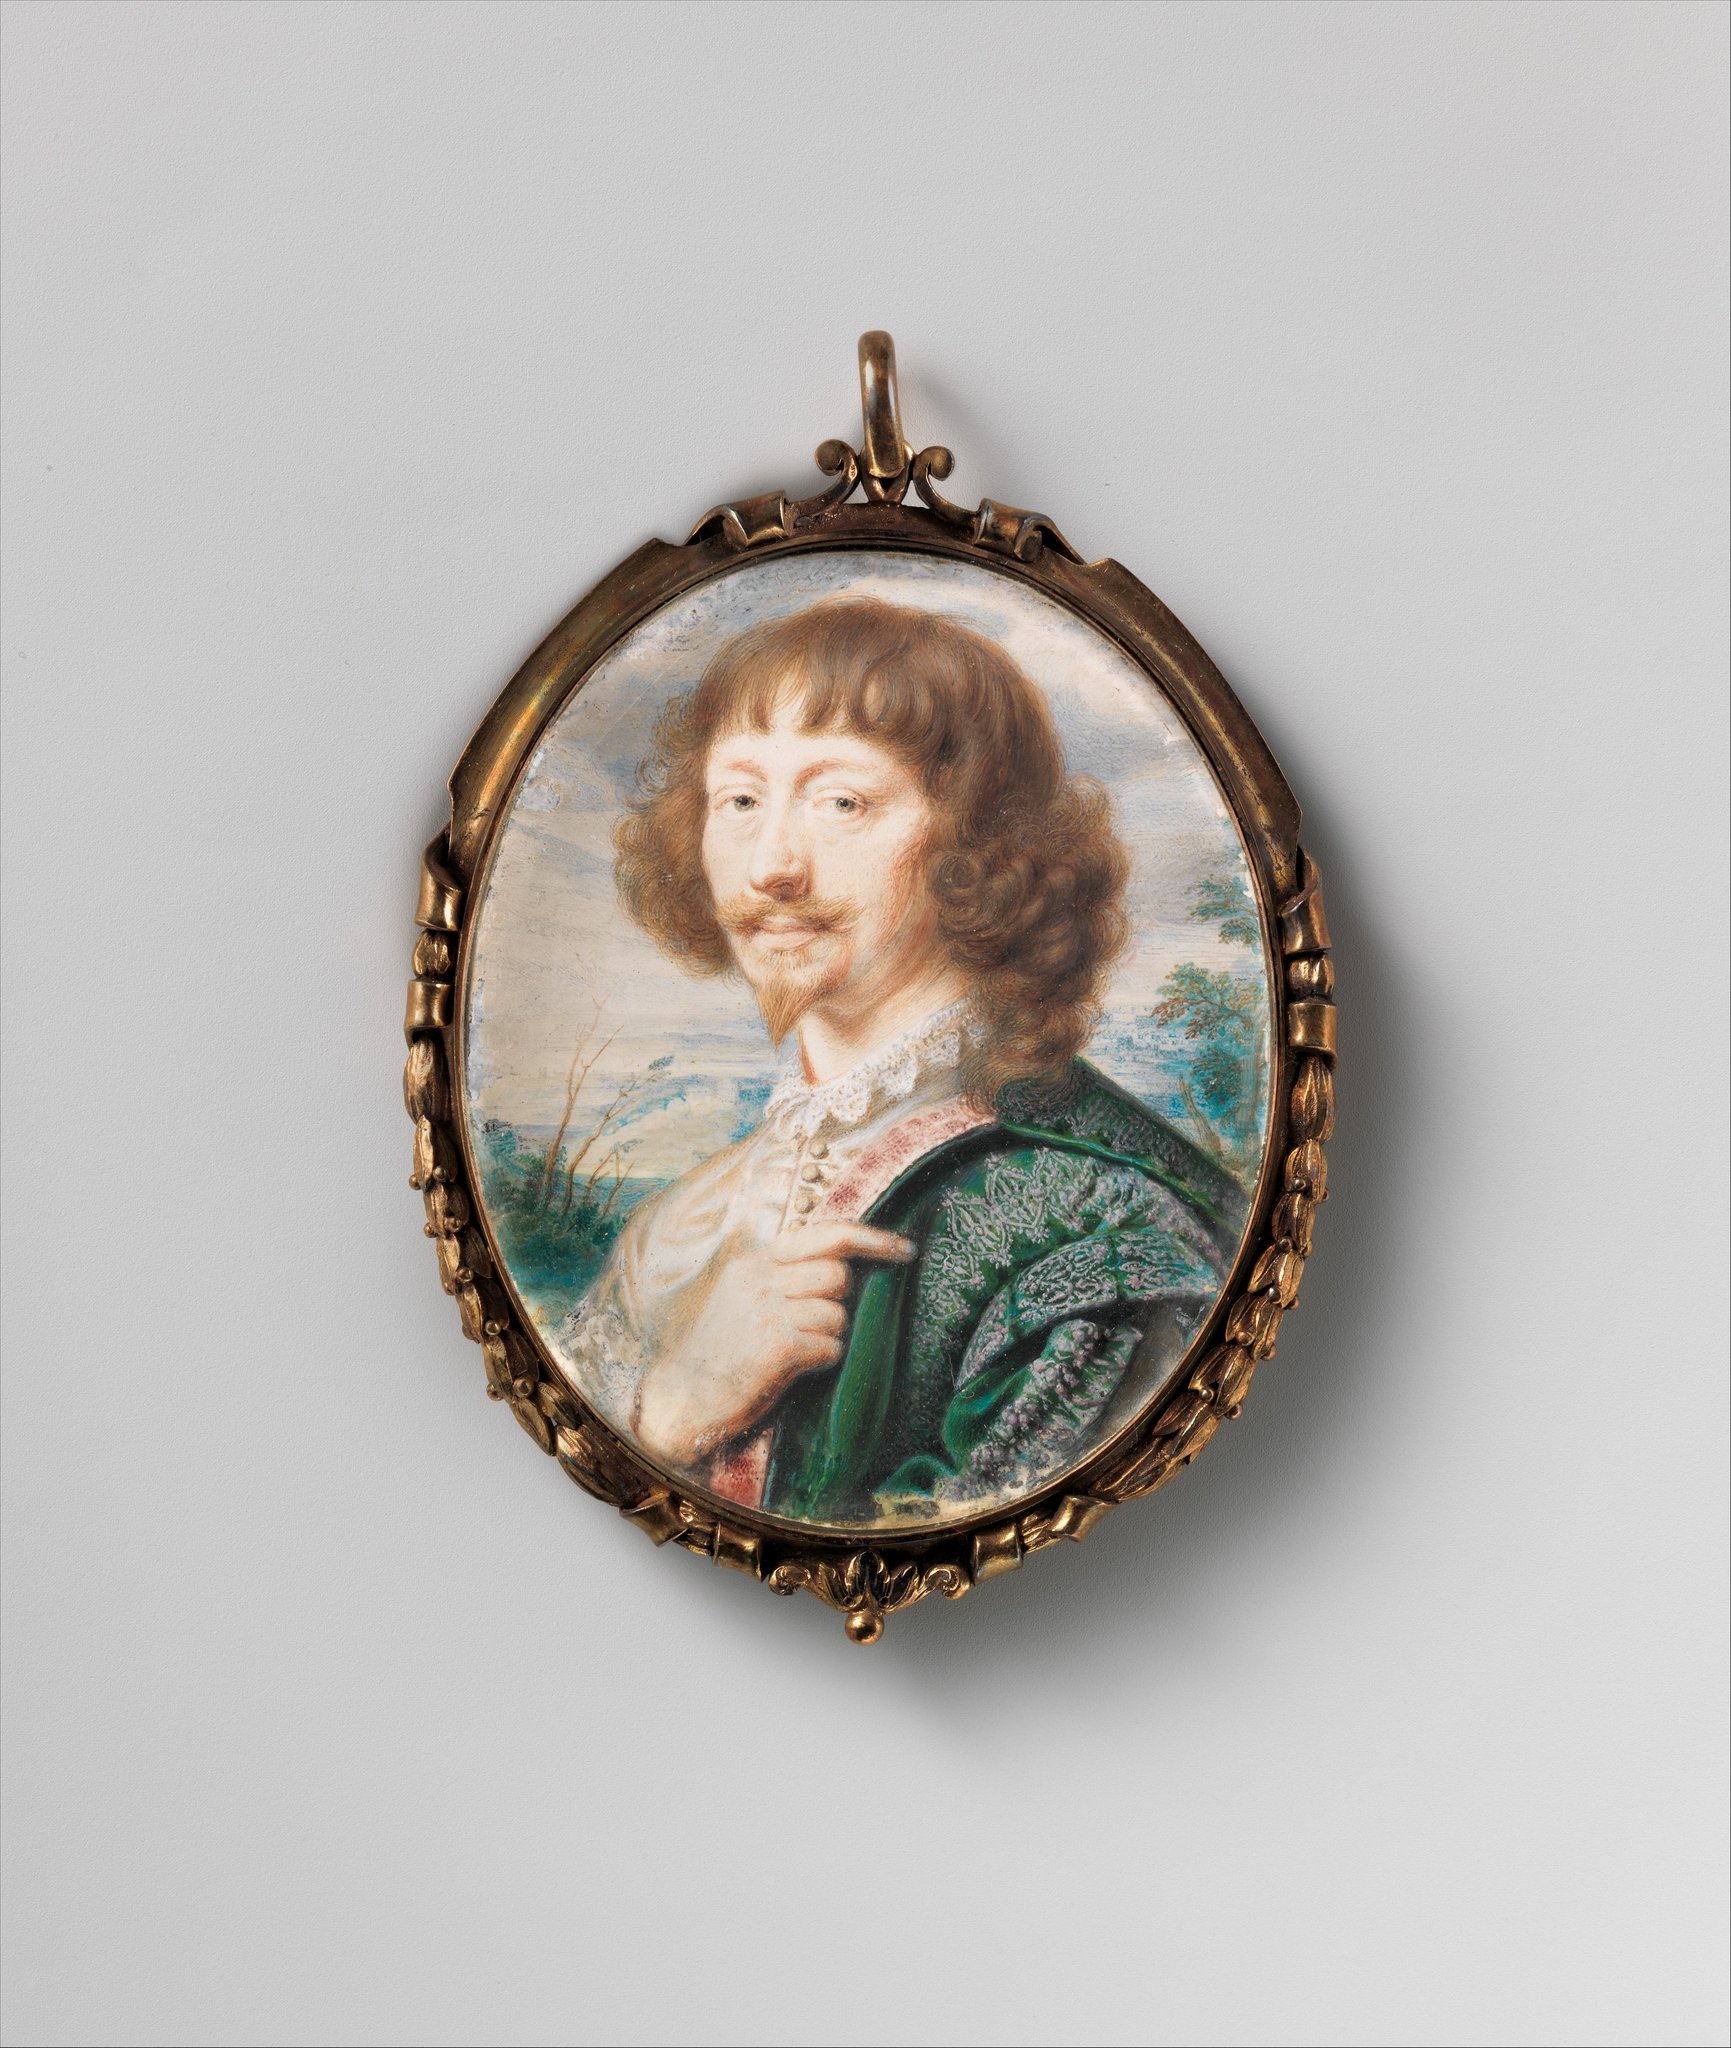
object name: painting, miniature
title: Endymion Porter (1587–1649)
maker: john hoskins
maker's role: artist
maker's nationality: british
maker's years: 1615-1665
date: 1630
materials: parchment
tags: men,portraits